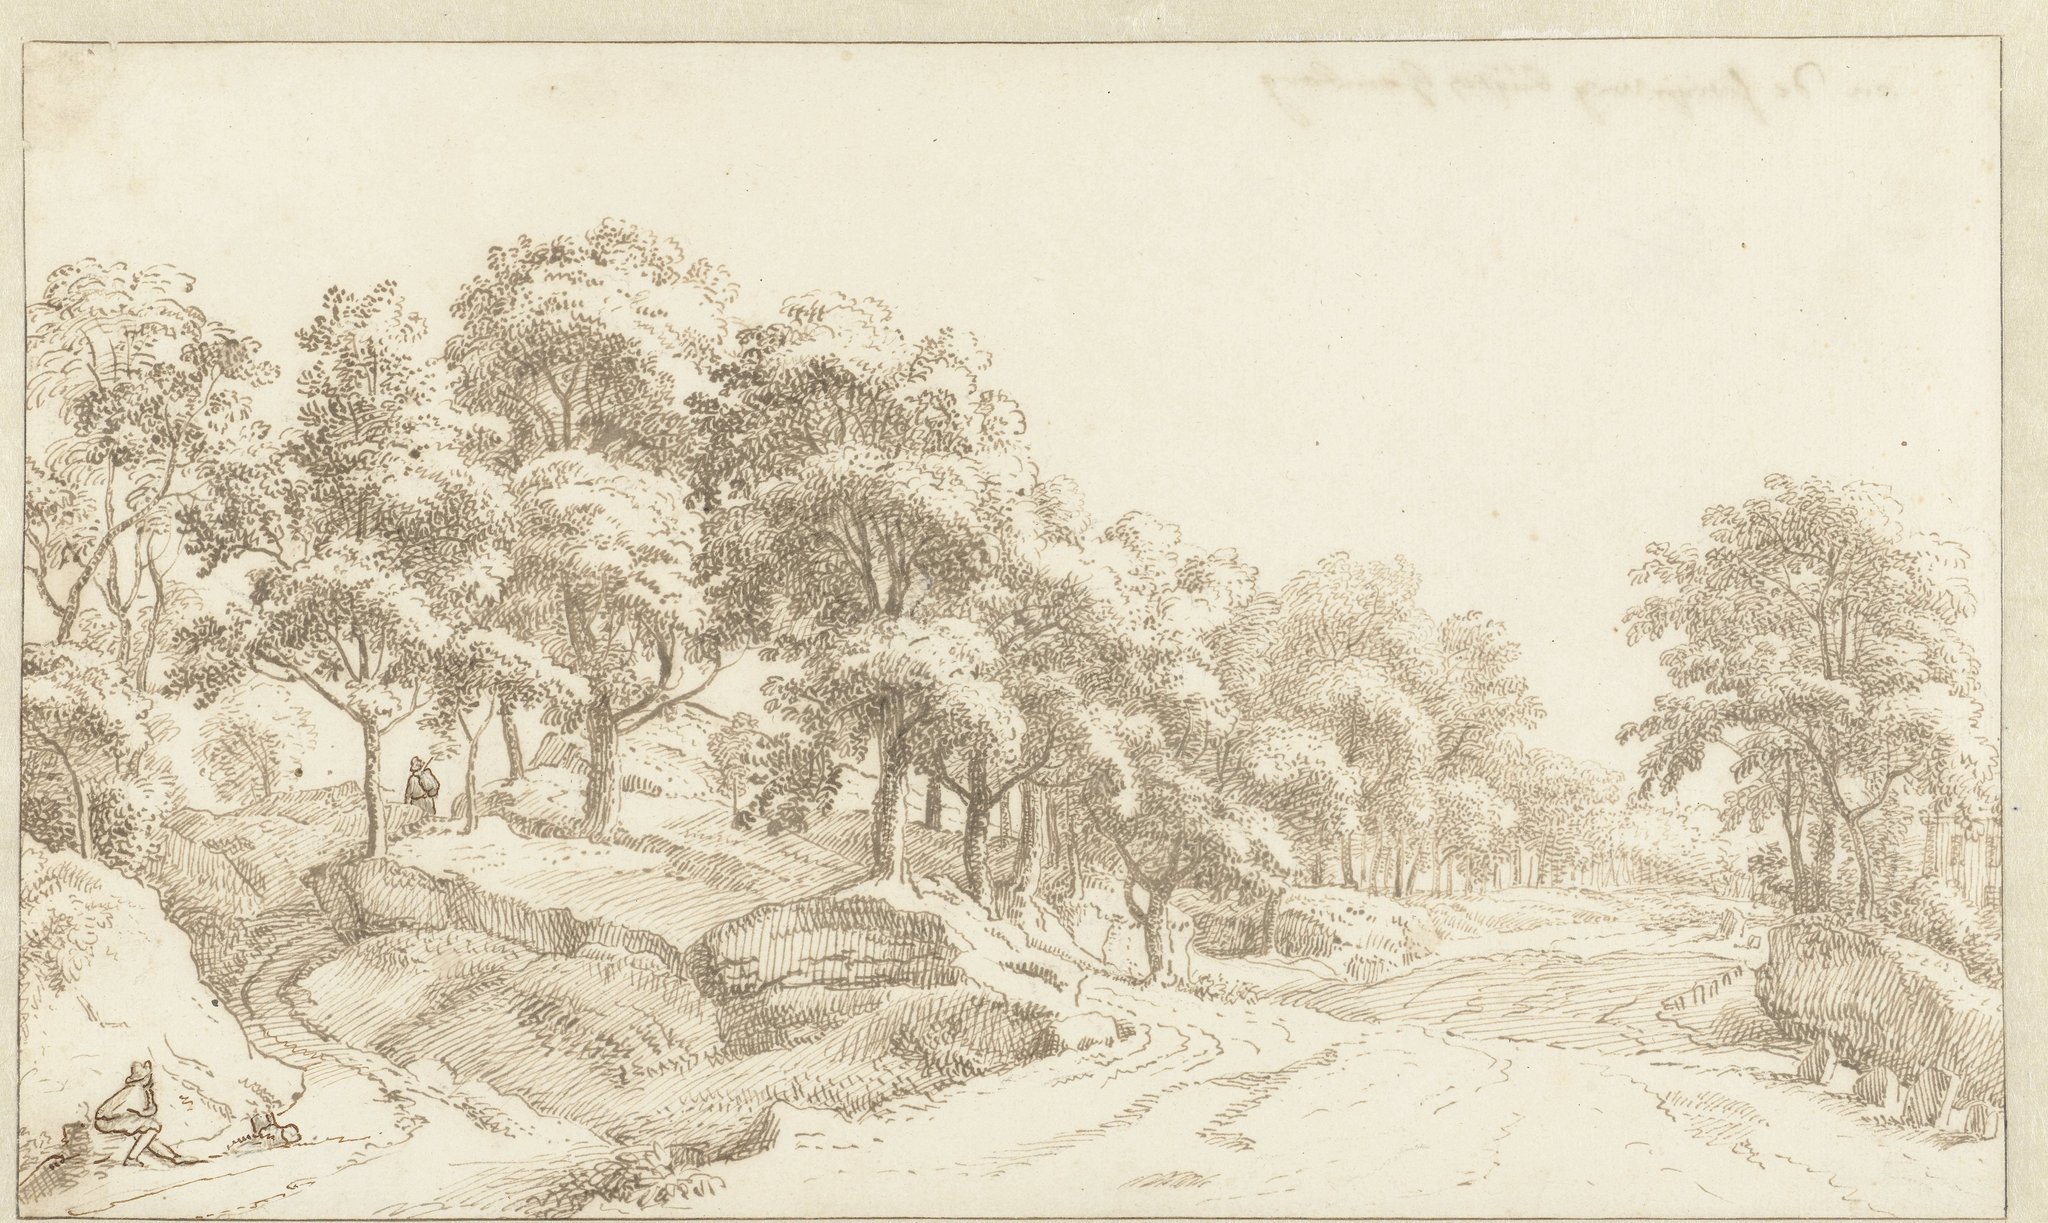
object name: drawing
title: Wooded Landscape along a Wide Road near Hamburg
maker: albert meyering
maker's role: draughtsman, print maker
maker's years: 1645-1714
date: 1679-1684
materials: ink, paper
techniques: pen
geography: hamburg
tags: landscapes in the temperate zone